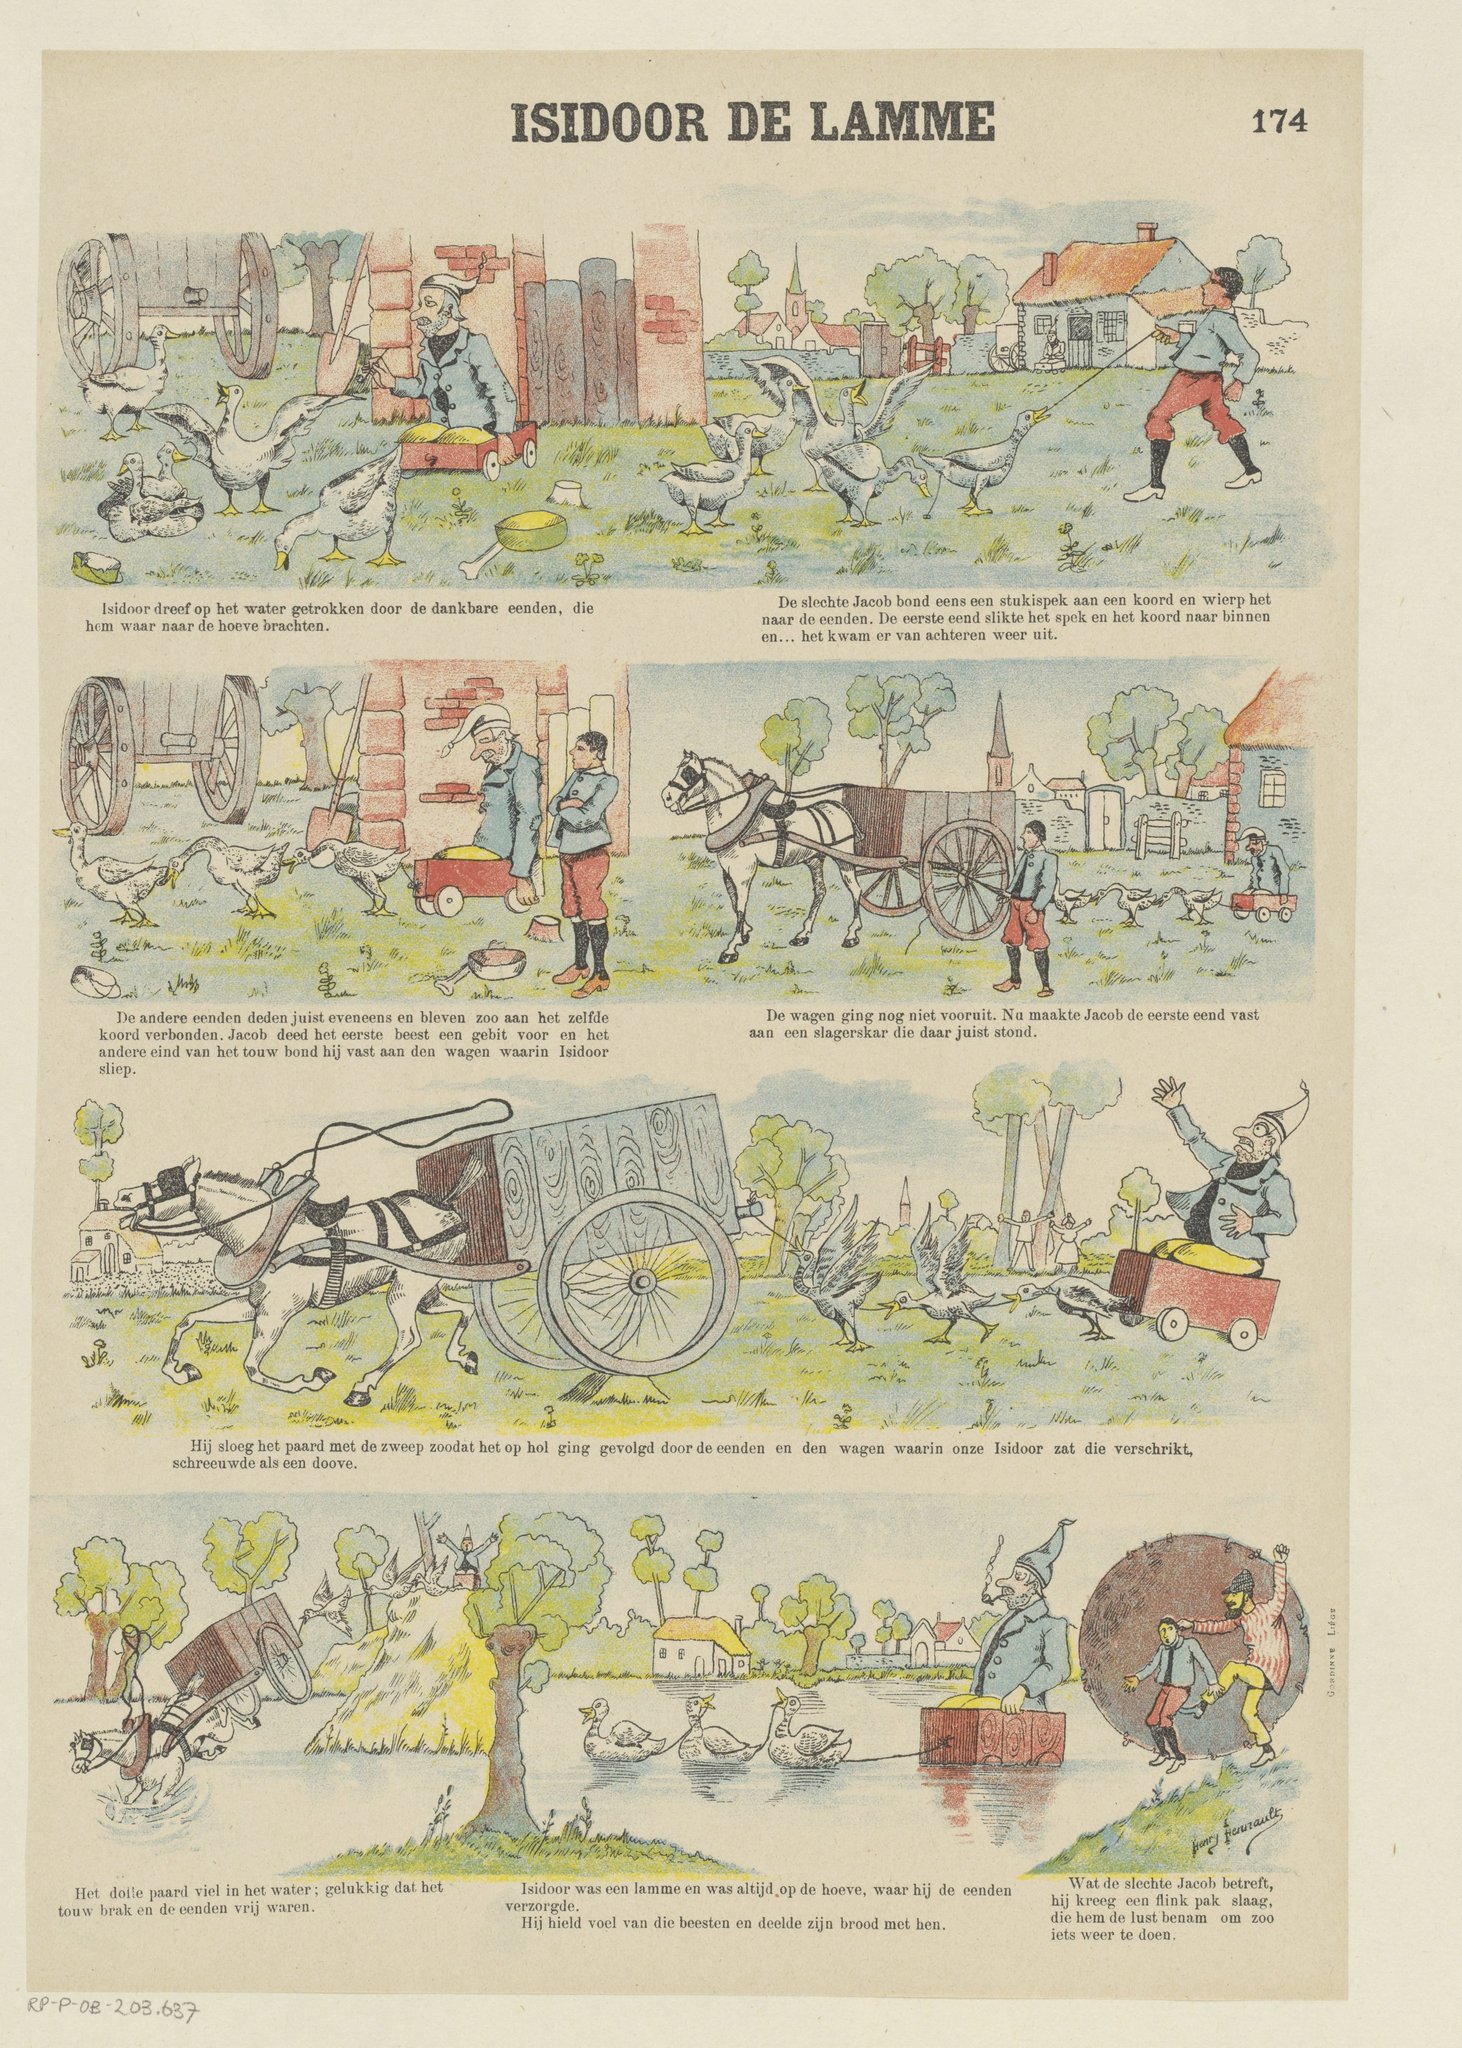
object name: print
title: Isidoor de lamme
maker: henry hennault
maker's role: print maker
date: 1894-1959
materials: paper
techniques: lithograph, letterpress printing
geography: liège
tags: paralytic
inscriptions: collector's mark: Lugt 2760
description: Blad met 4 horizontale rijen met voorstellingen over Isidoor de lamme die wordt voortgetrokken door een paard en wagen en drie ganzen. Onder elke afbeelding een onderschrift. Genummerd rechtsboven: No 174.